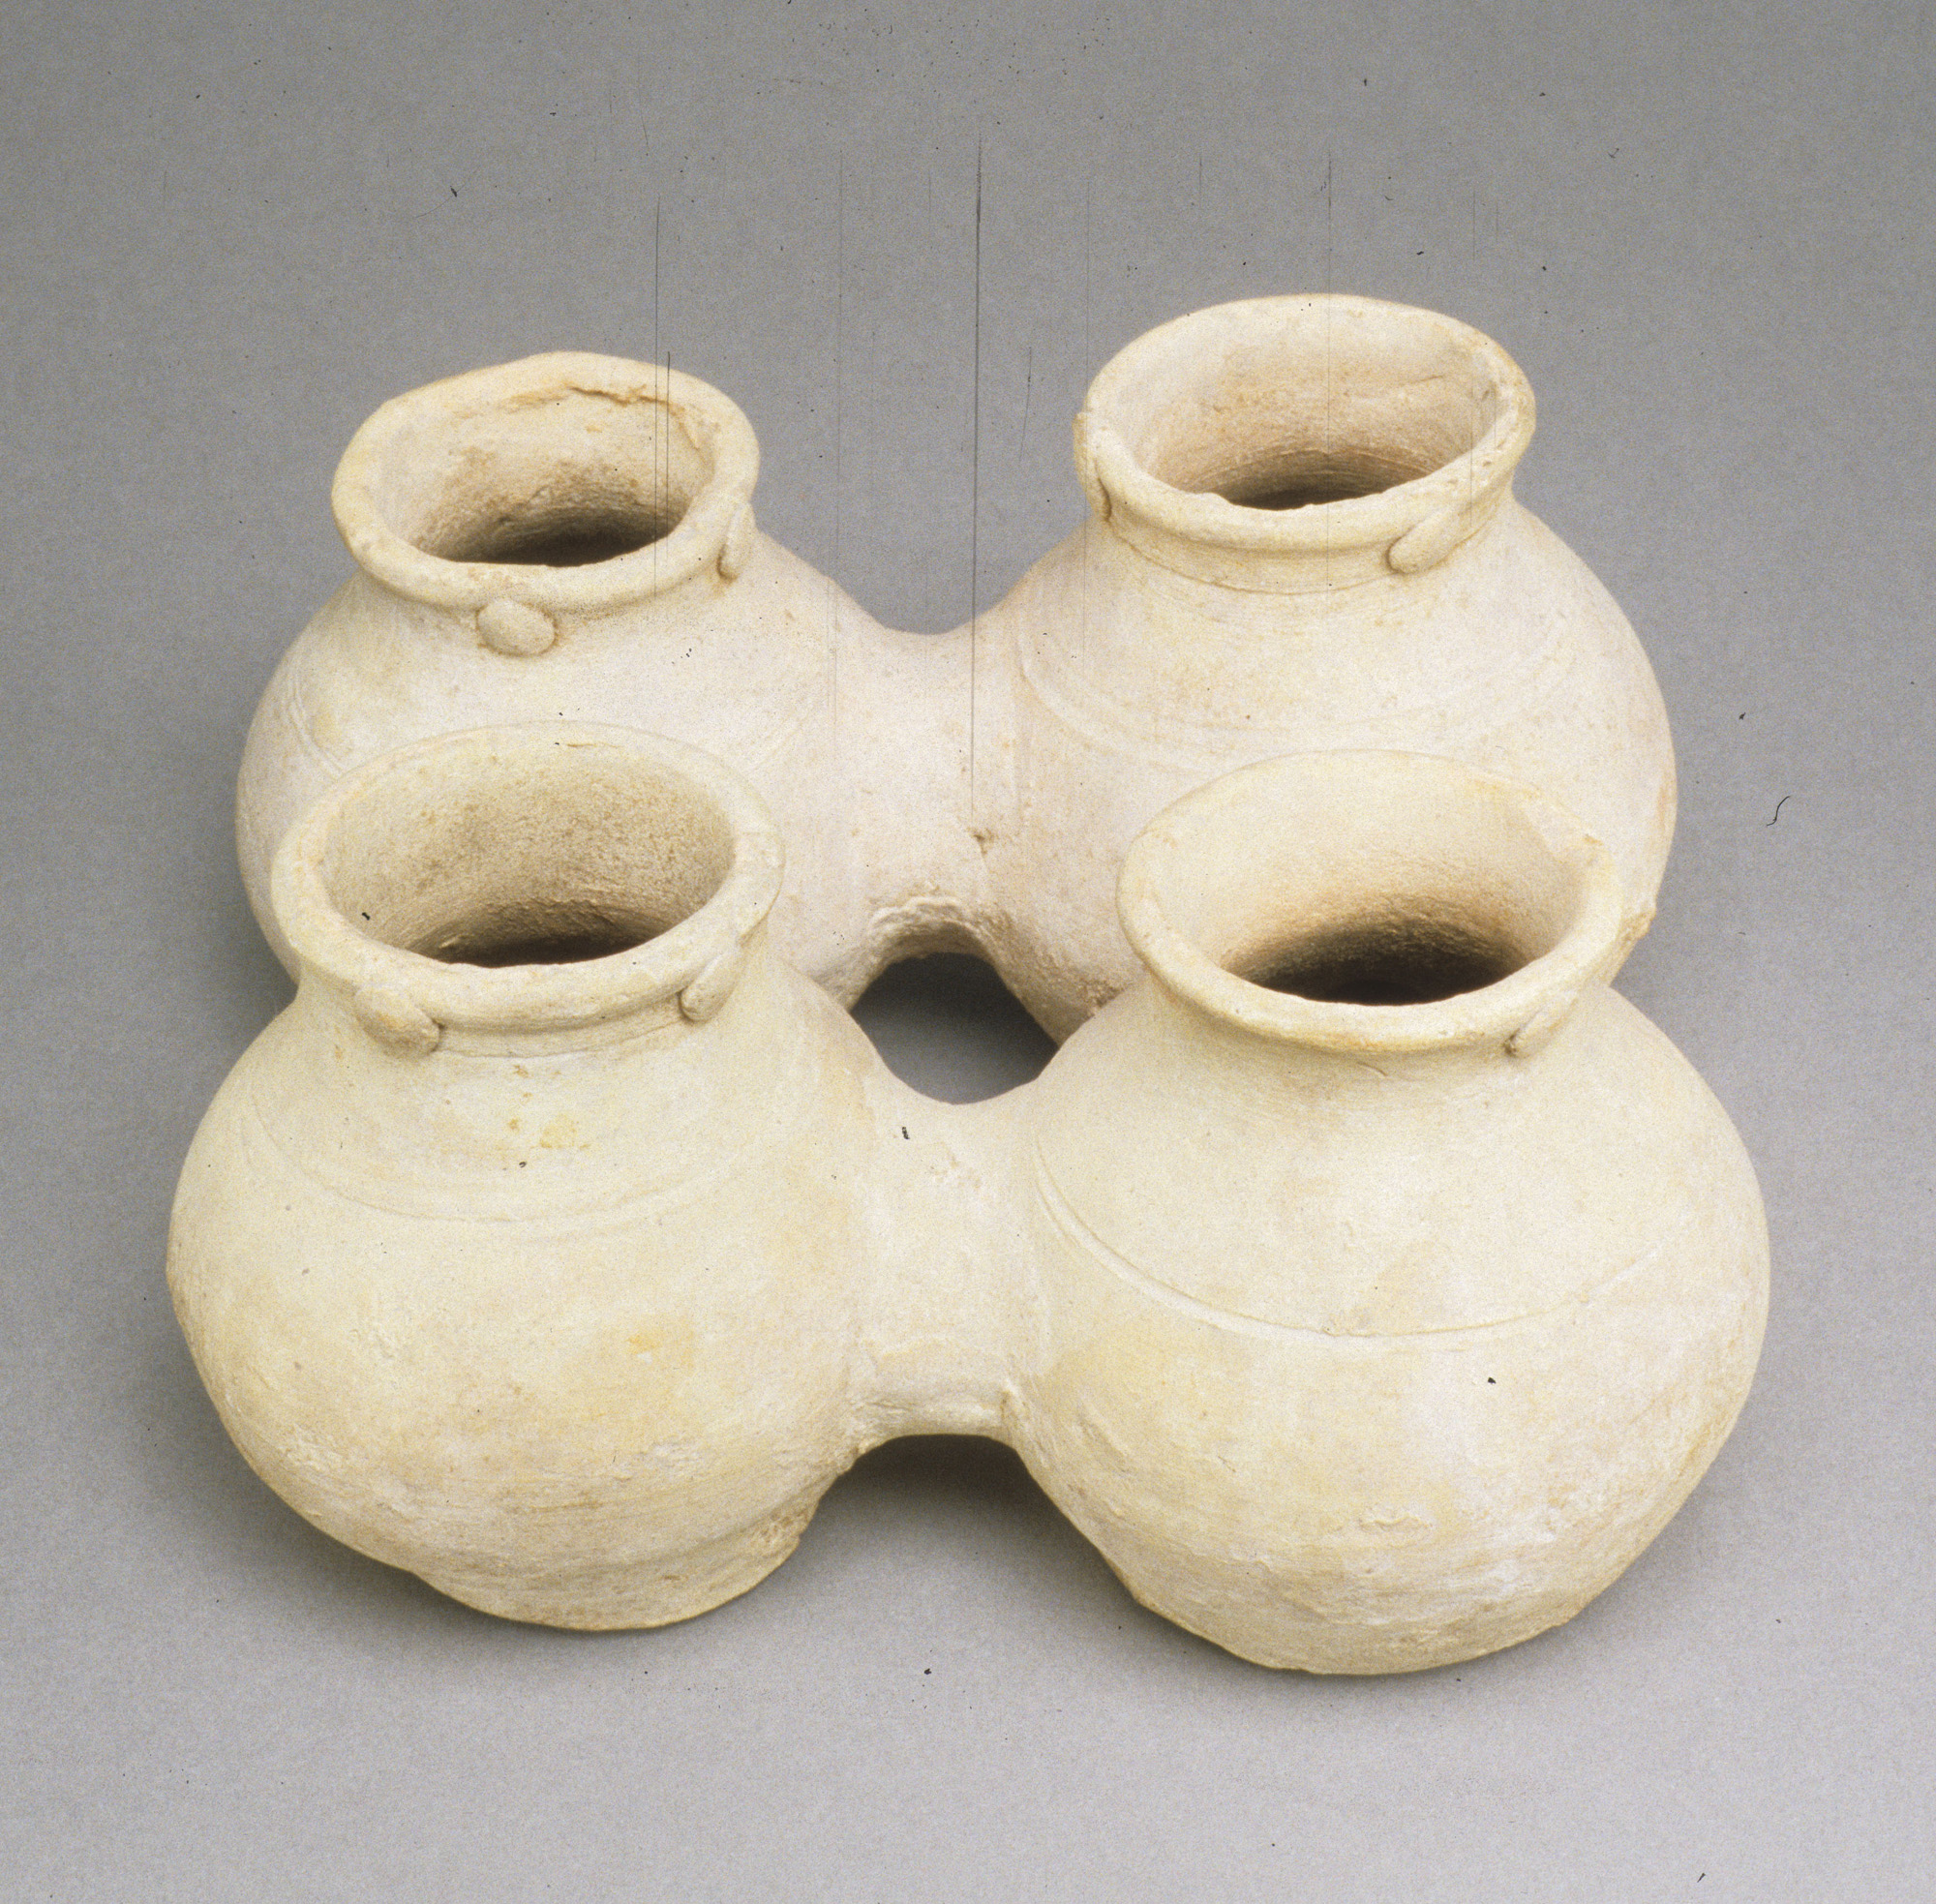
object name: vase, quadruple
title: Quadruple Offering Vase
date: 2100-2010 BCE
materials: pottery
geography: egypt